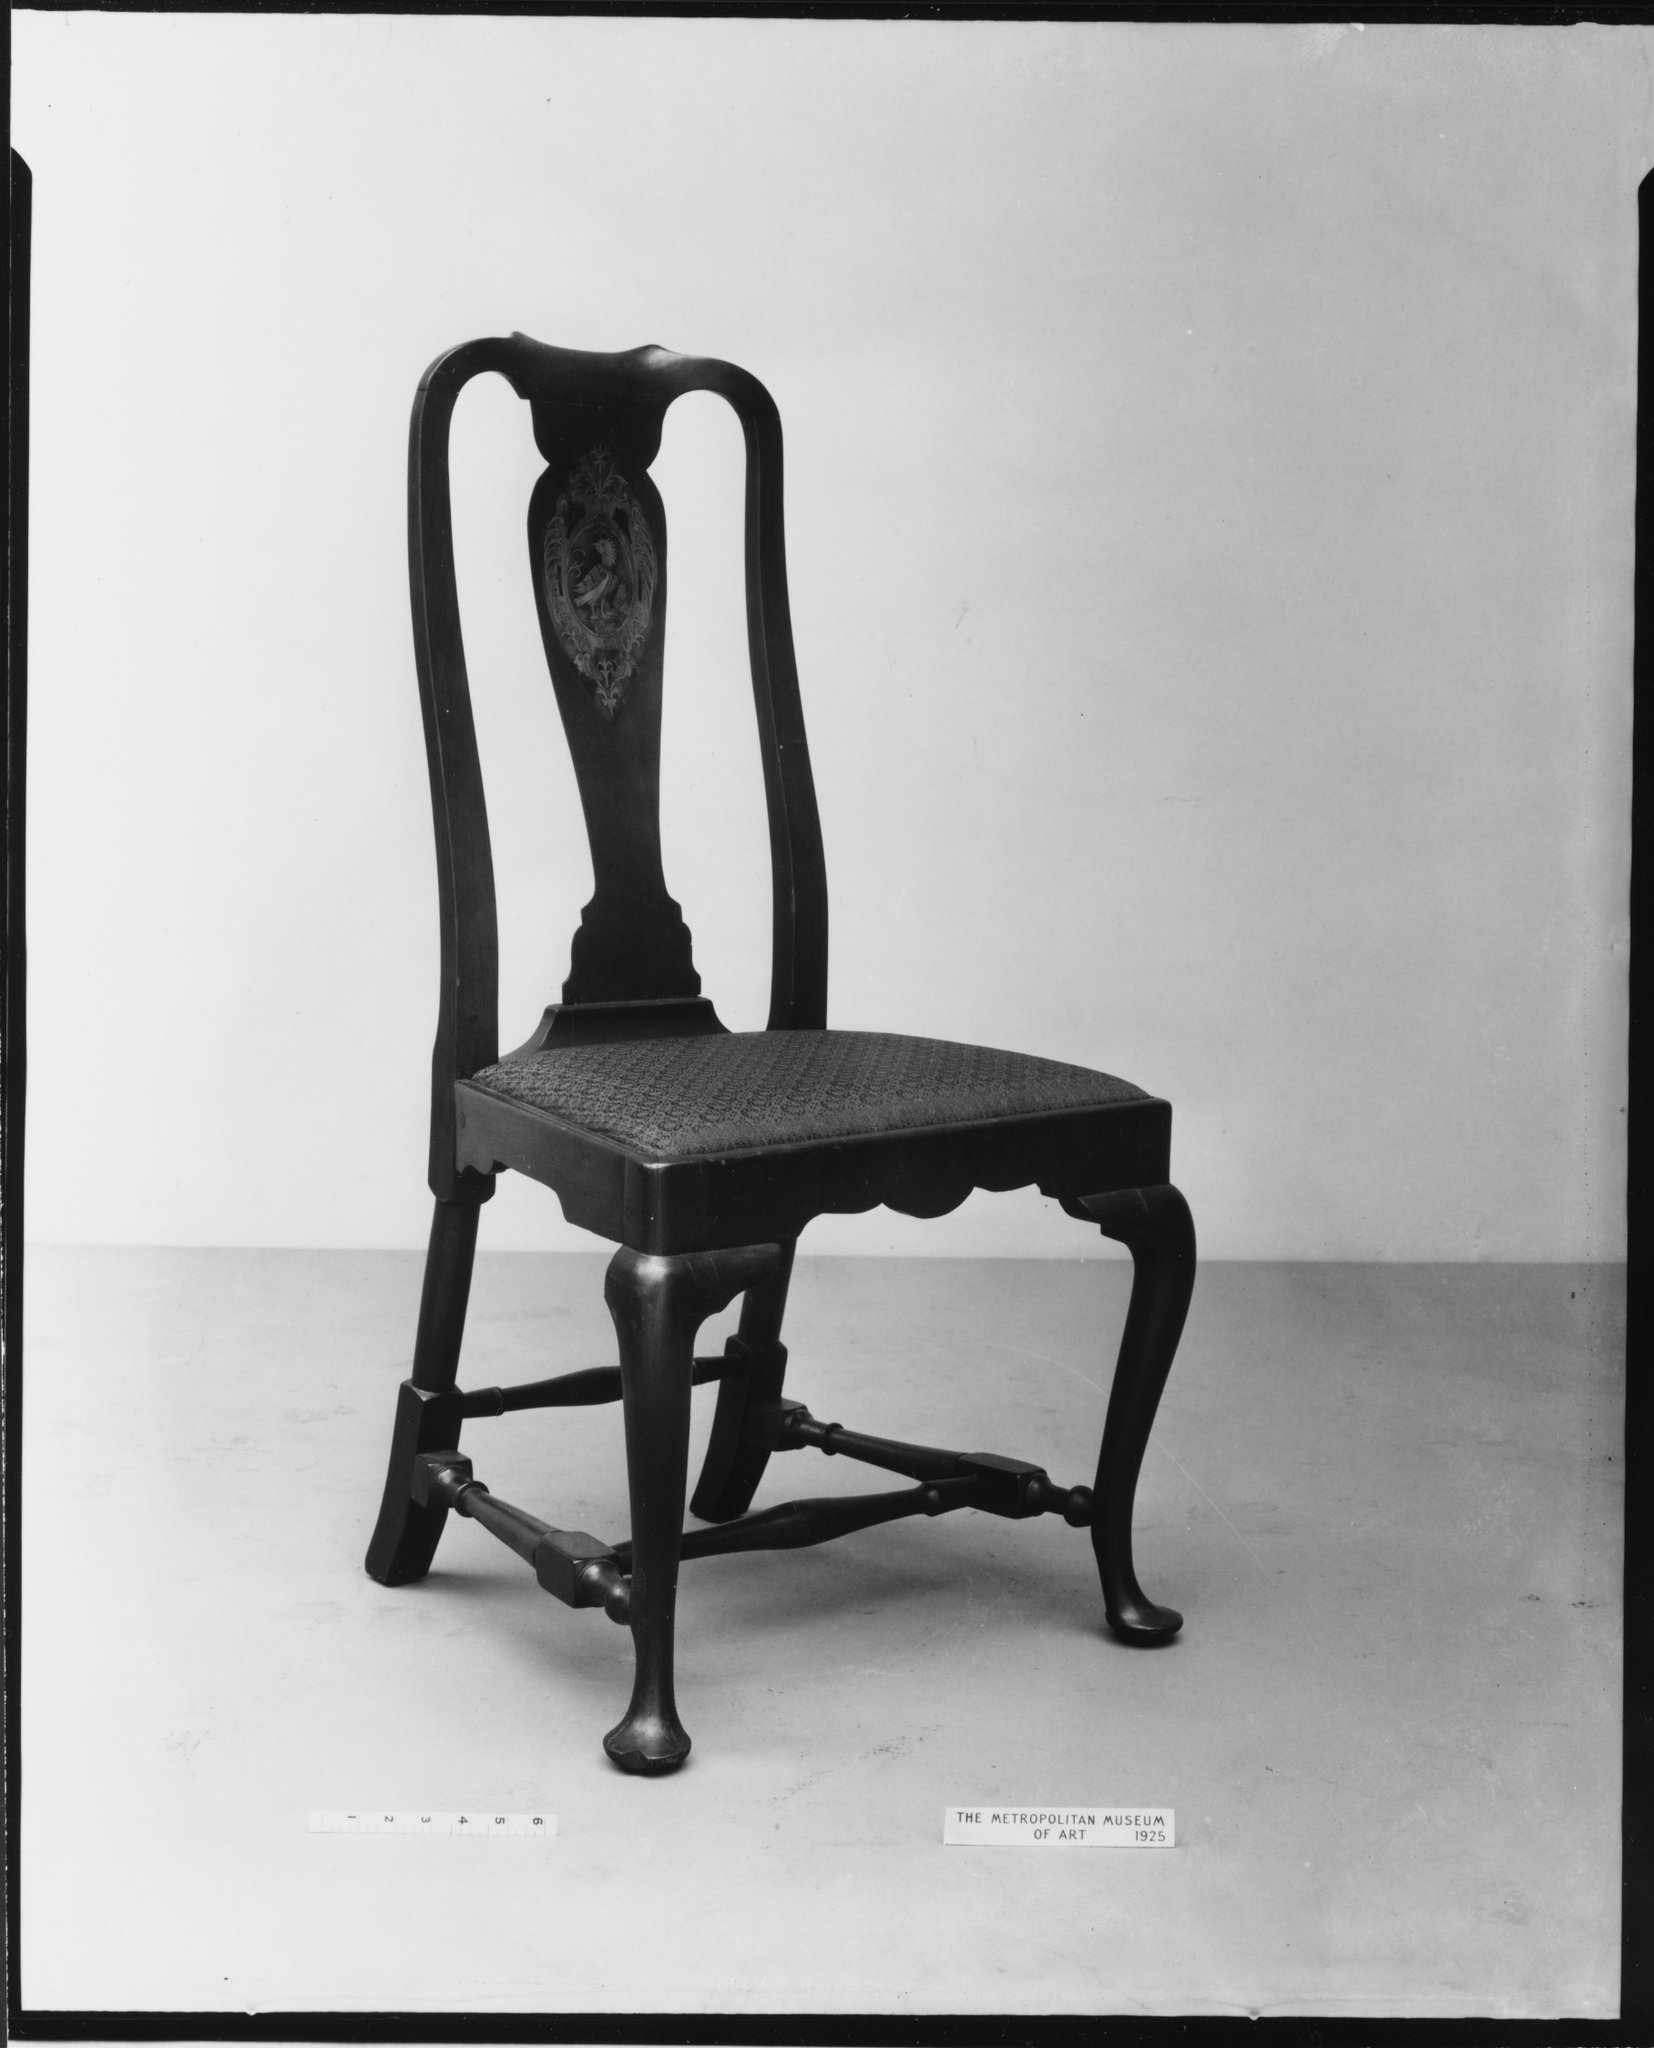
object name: side chair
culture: american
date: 1730-1790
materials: wood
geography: united states